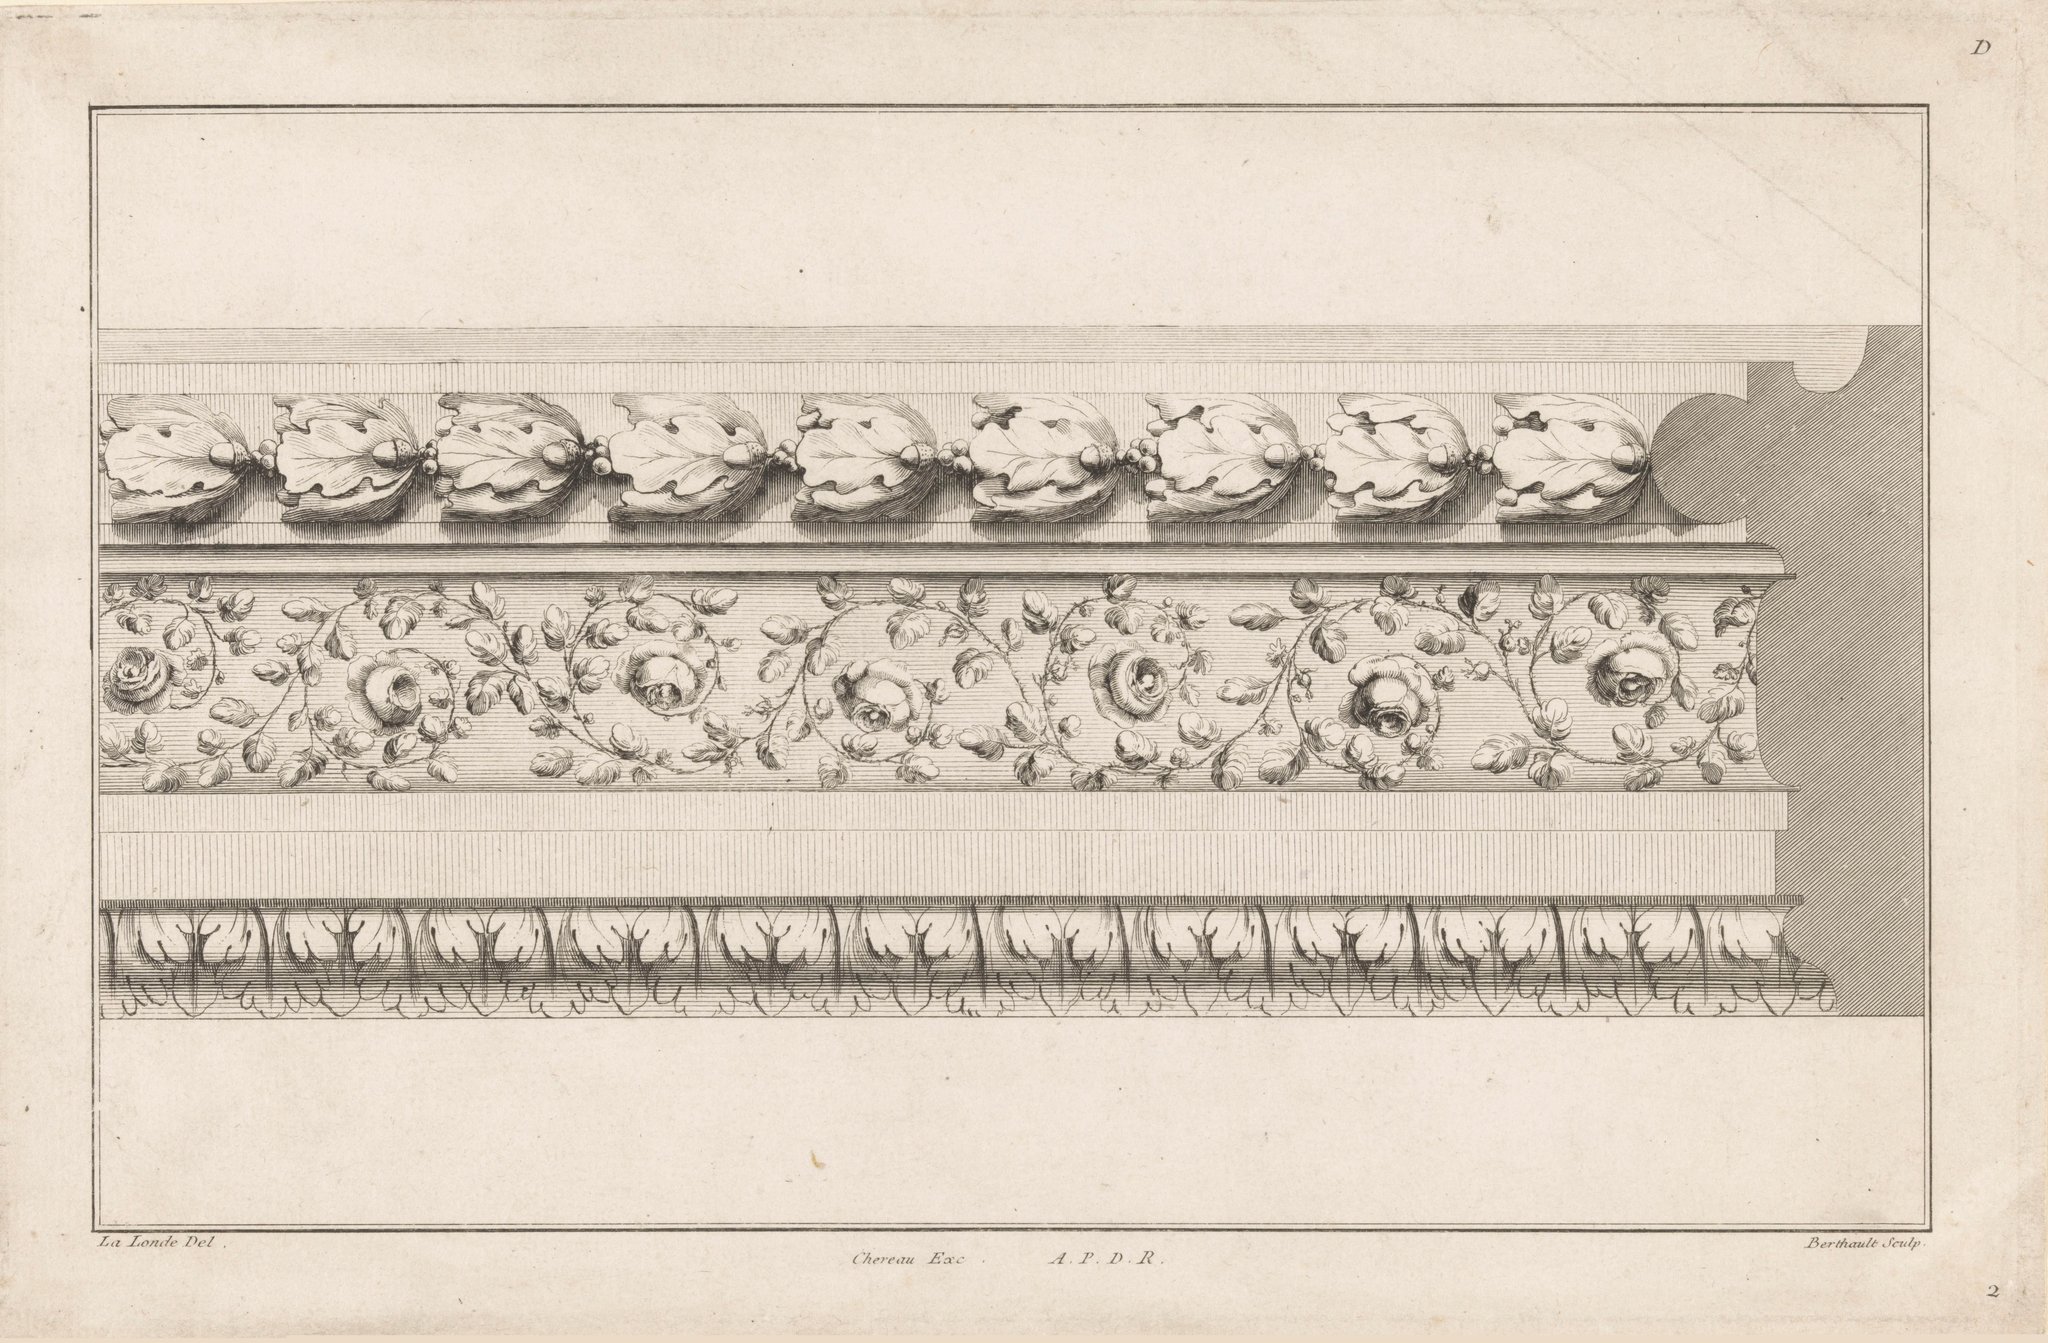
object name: ornament print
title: Lijst met eikenbladeren en rozen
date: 1784-1785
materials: paper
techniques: engraving, etching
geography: paris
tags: ornaments ~ art (+ framing decorations)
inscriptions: collector's mark: Lugt 2760, collector's mark: Lugt 2228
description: Een geornamenteerde lijst met eikenbladeren, ranken met rozen en acanthusbladeren.